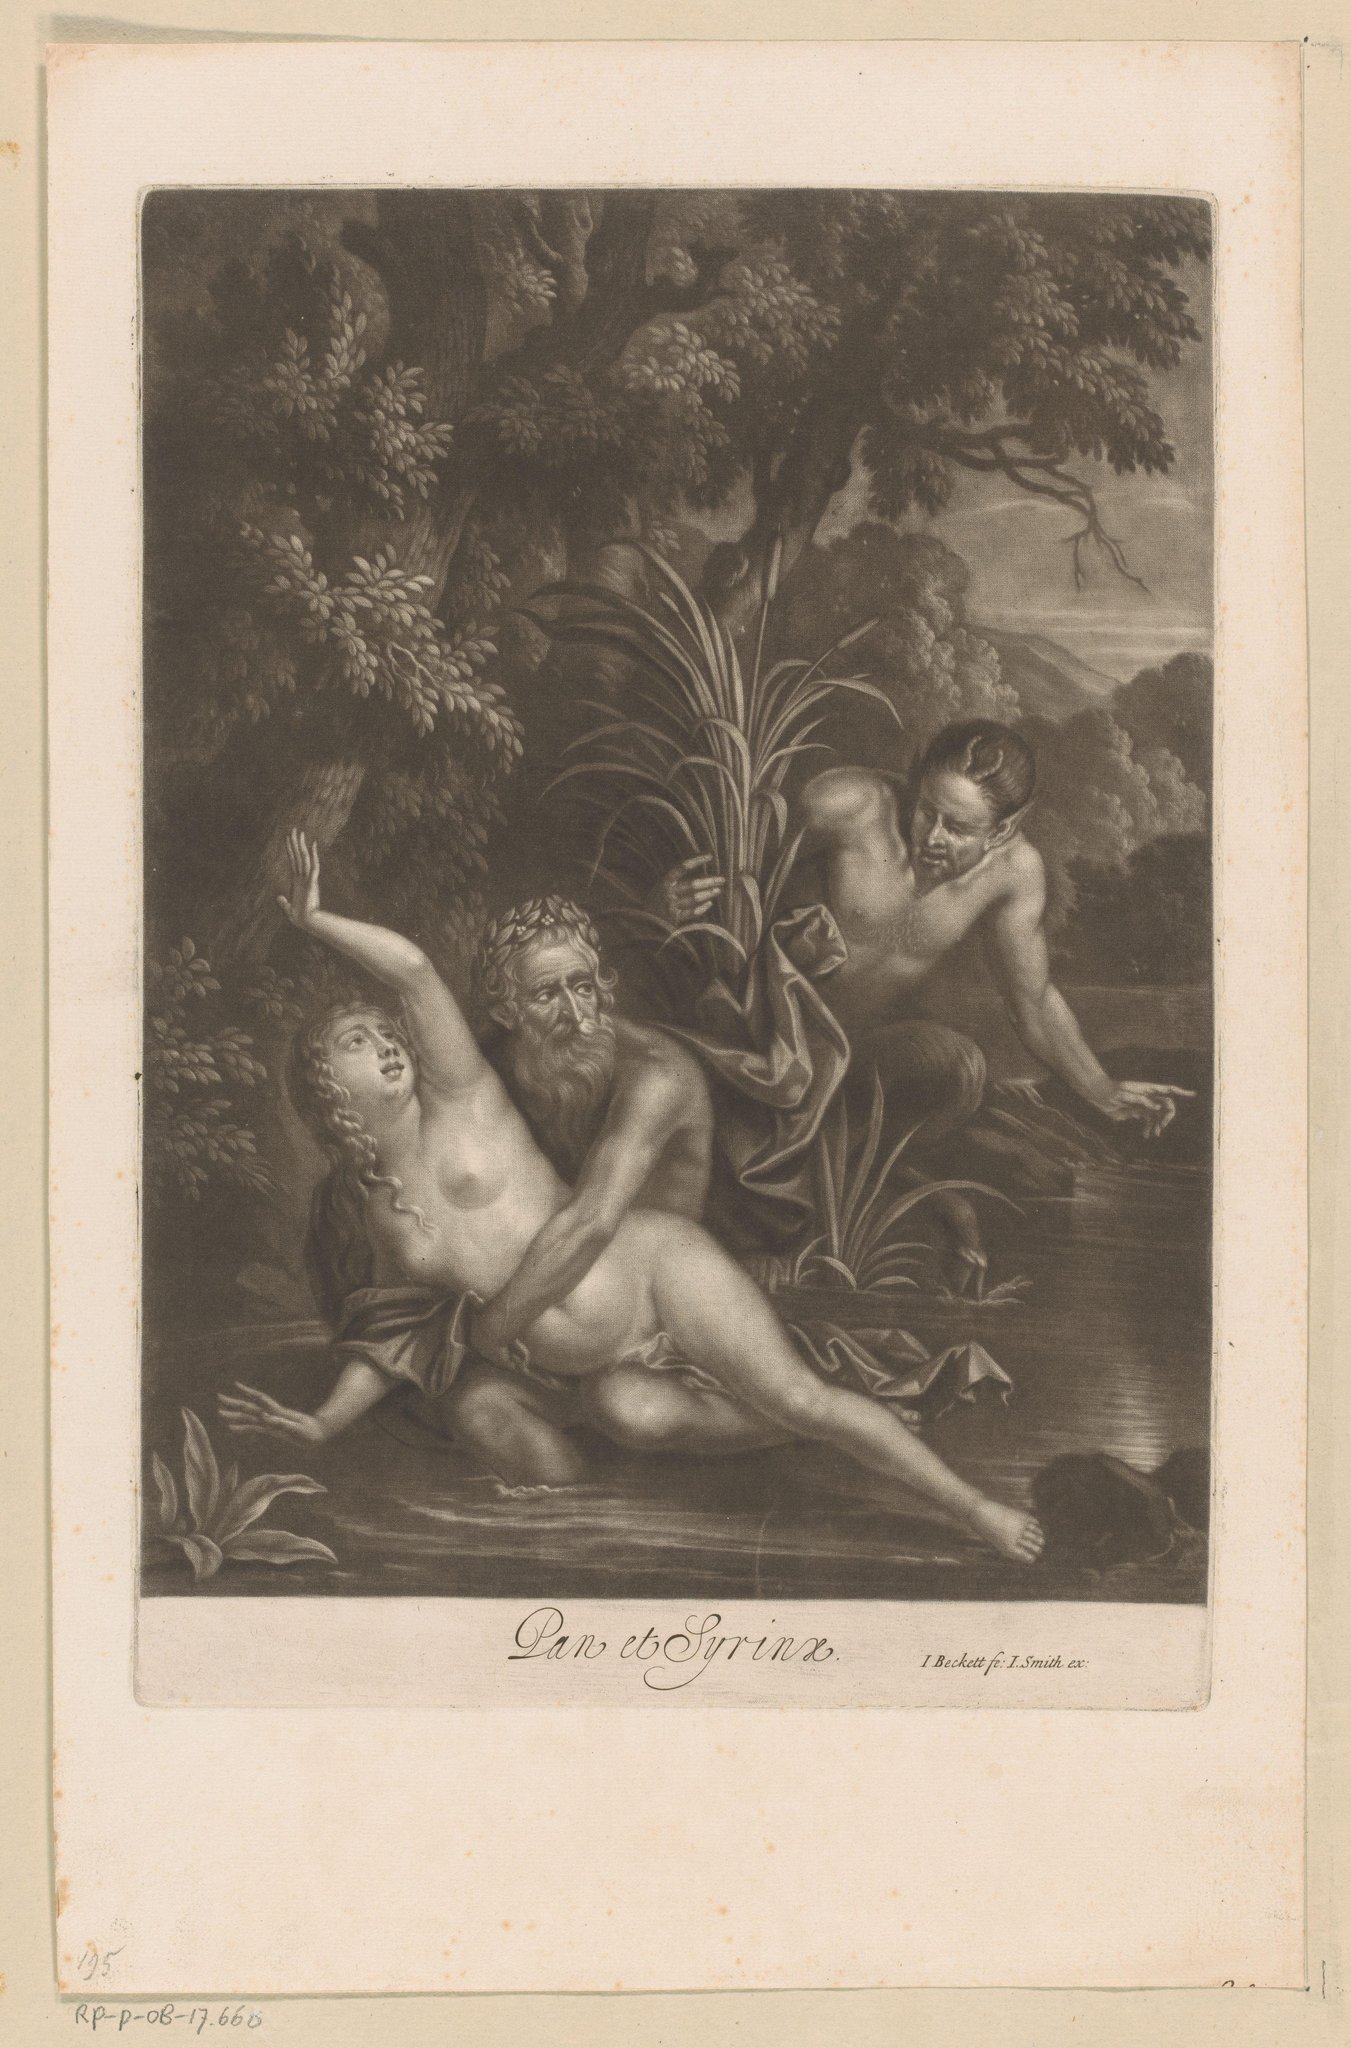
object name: print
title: Pan en Syrinx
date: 1681-1688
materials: paper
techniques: mezzotint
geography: london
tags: syrinx changed into a reed: while fleeing from pan, the nymph syrinx is changed into reed by her sisters, the naiads (ovid, metamorphoses i 705)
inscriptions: collector's mark: Lugt 240